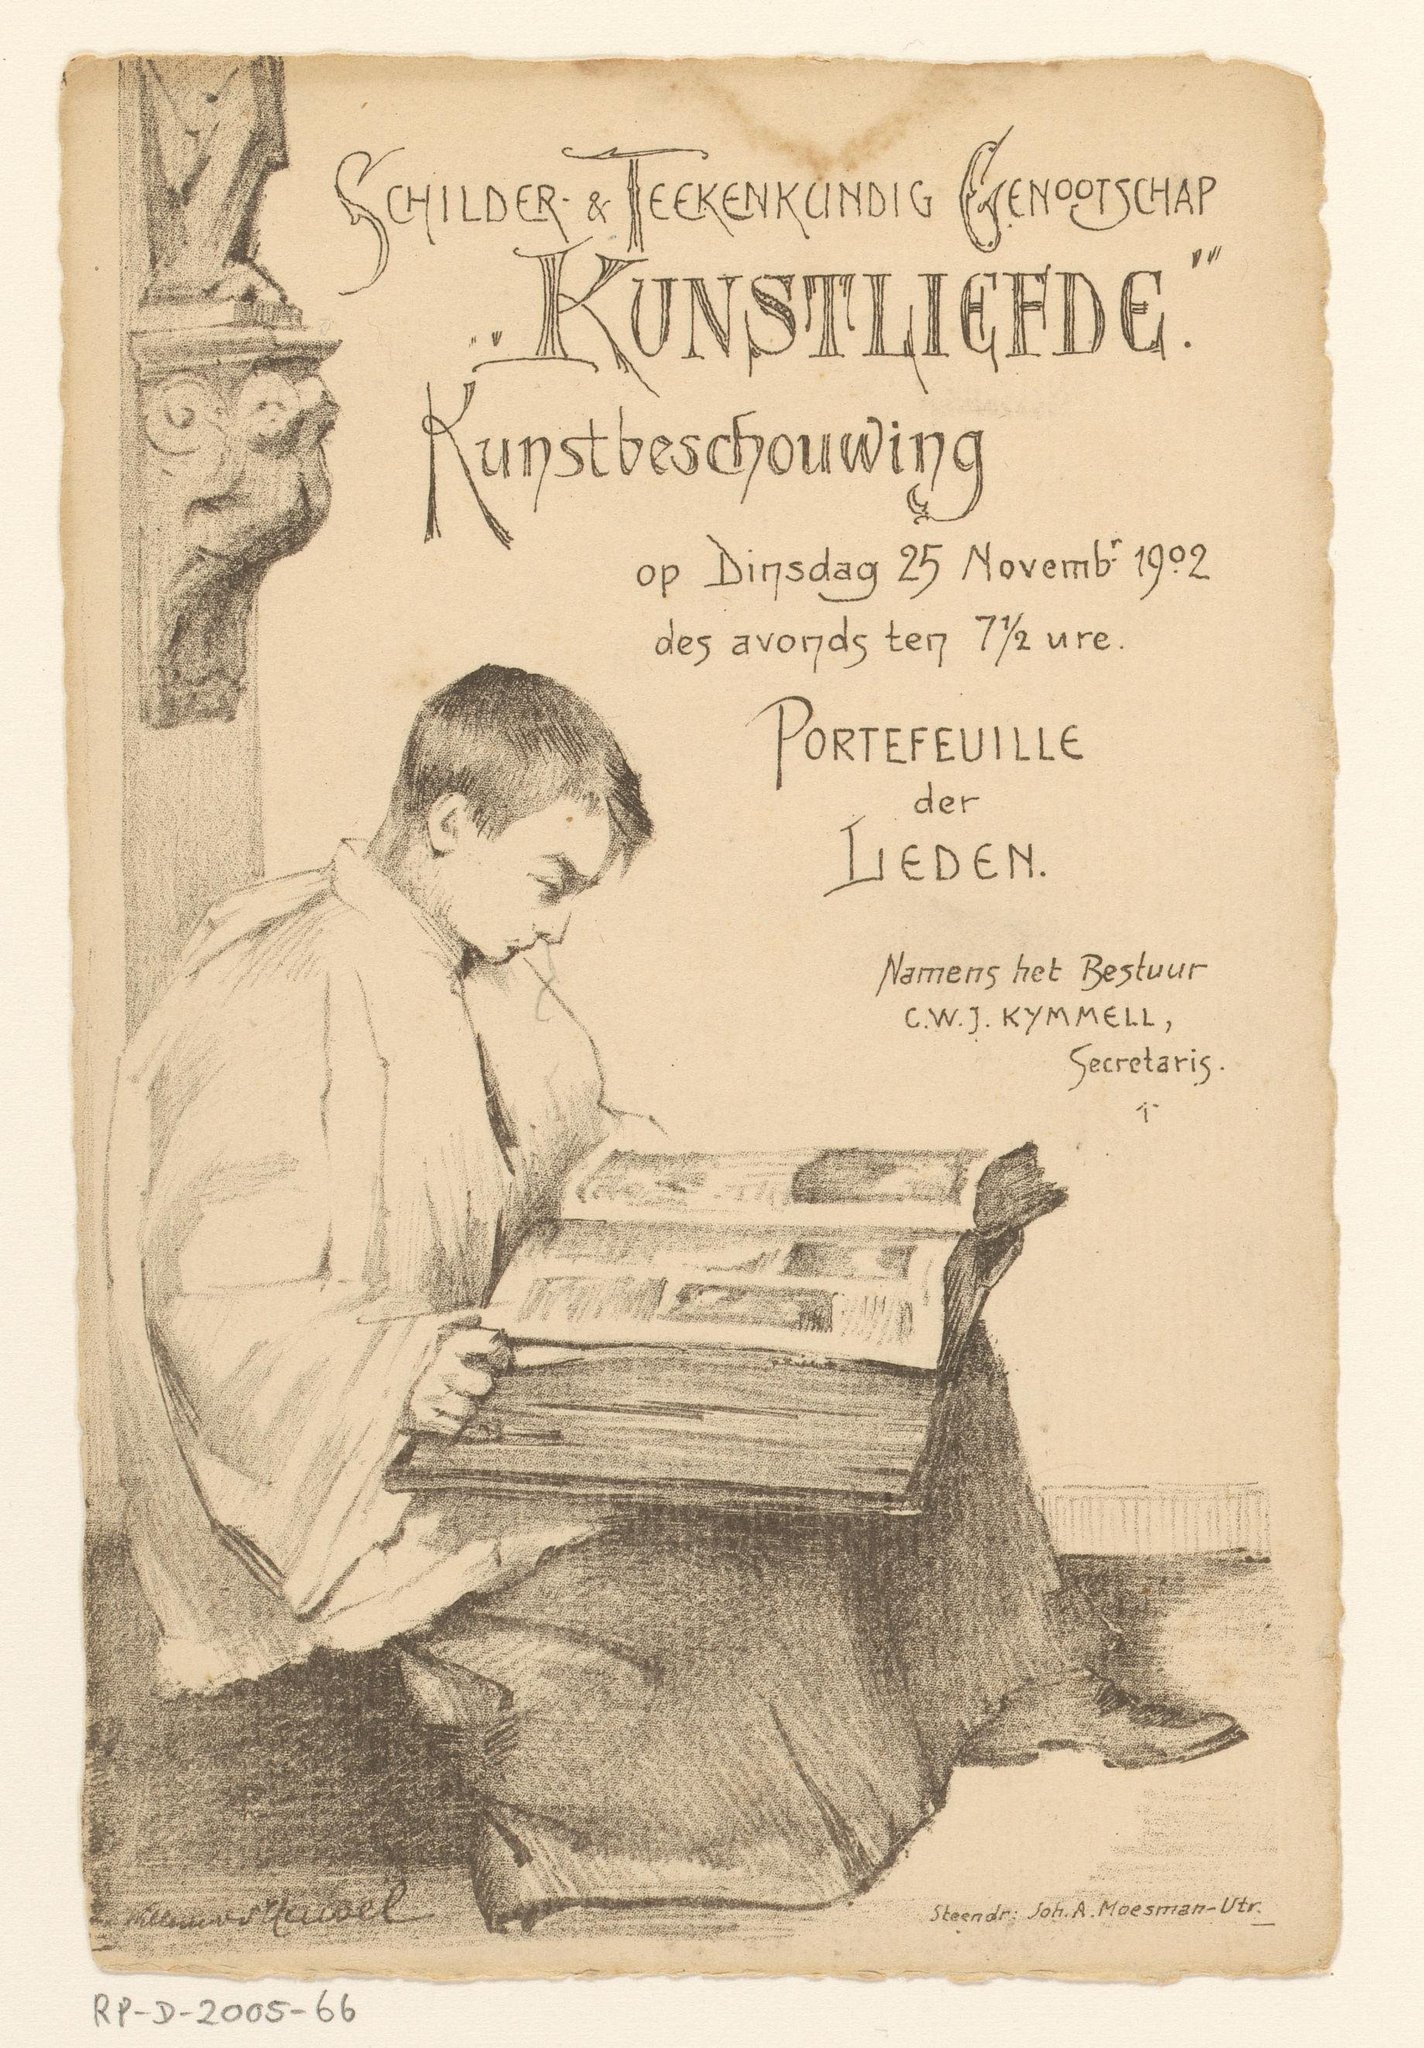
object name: invitation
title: Uitnodiging van Schilder- en Teekenkundig Genootschap "Kunstliefde" voor een kunstbeschouwing, 25 november 1902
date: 1902-1911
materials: paper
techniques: lithograph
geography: netherlands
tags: criticizing and discussing art, art criticism, circle, club of artists, collecting and exhibiting products of the fine arts, book in which illustrations are essential - mm - book open, organization, functionaries and dignitaries in roman catholic church; clergy in general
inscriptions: collector's mark: Lugt 2228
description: Koorknaap met prentenbijbel op schoot. Uitnodiging van Schilder- en Teekenkundig Genootschap "Kunstliefde" voor een kunstbeschouwing op 25 november 1902 van de portefeuille van de leden.